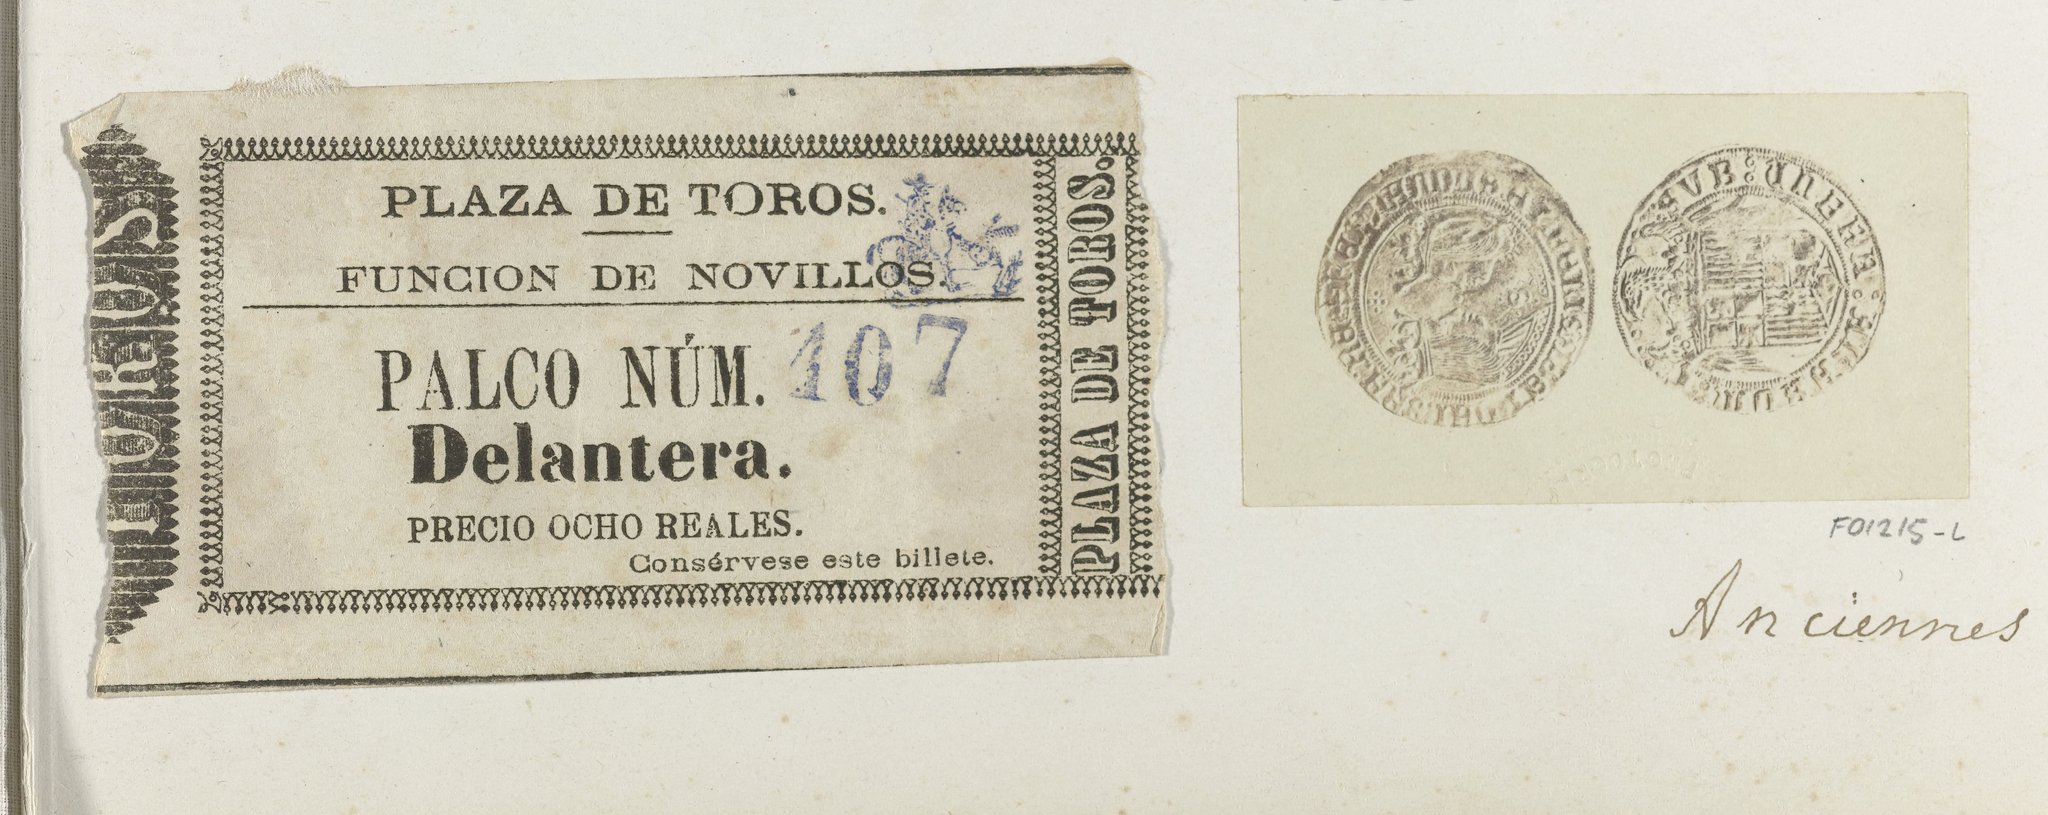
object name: printed matter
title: Plaatsbewijs voor een stierengevecht en (vermoedelijk) Spaanse munten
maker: charles clifford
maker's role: fotograaf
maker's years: 1819-1863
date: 1850-1863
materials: paper, photographic support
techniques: albumen print, printed materials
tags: coin, printed matter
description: Onderdeel van Reisalbum met opnames van kunstwerken, personen en bezienswaardigheden in Spanje.